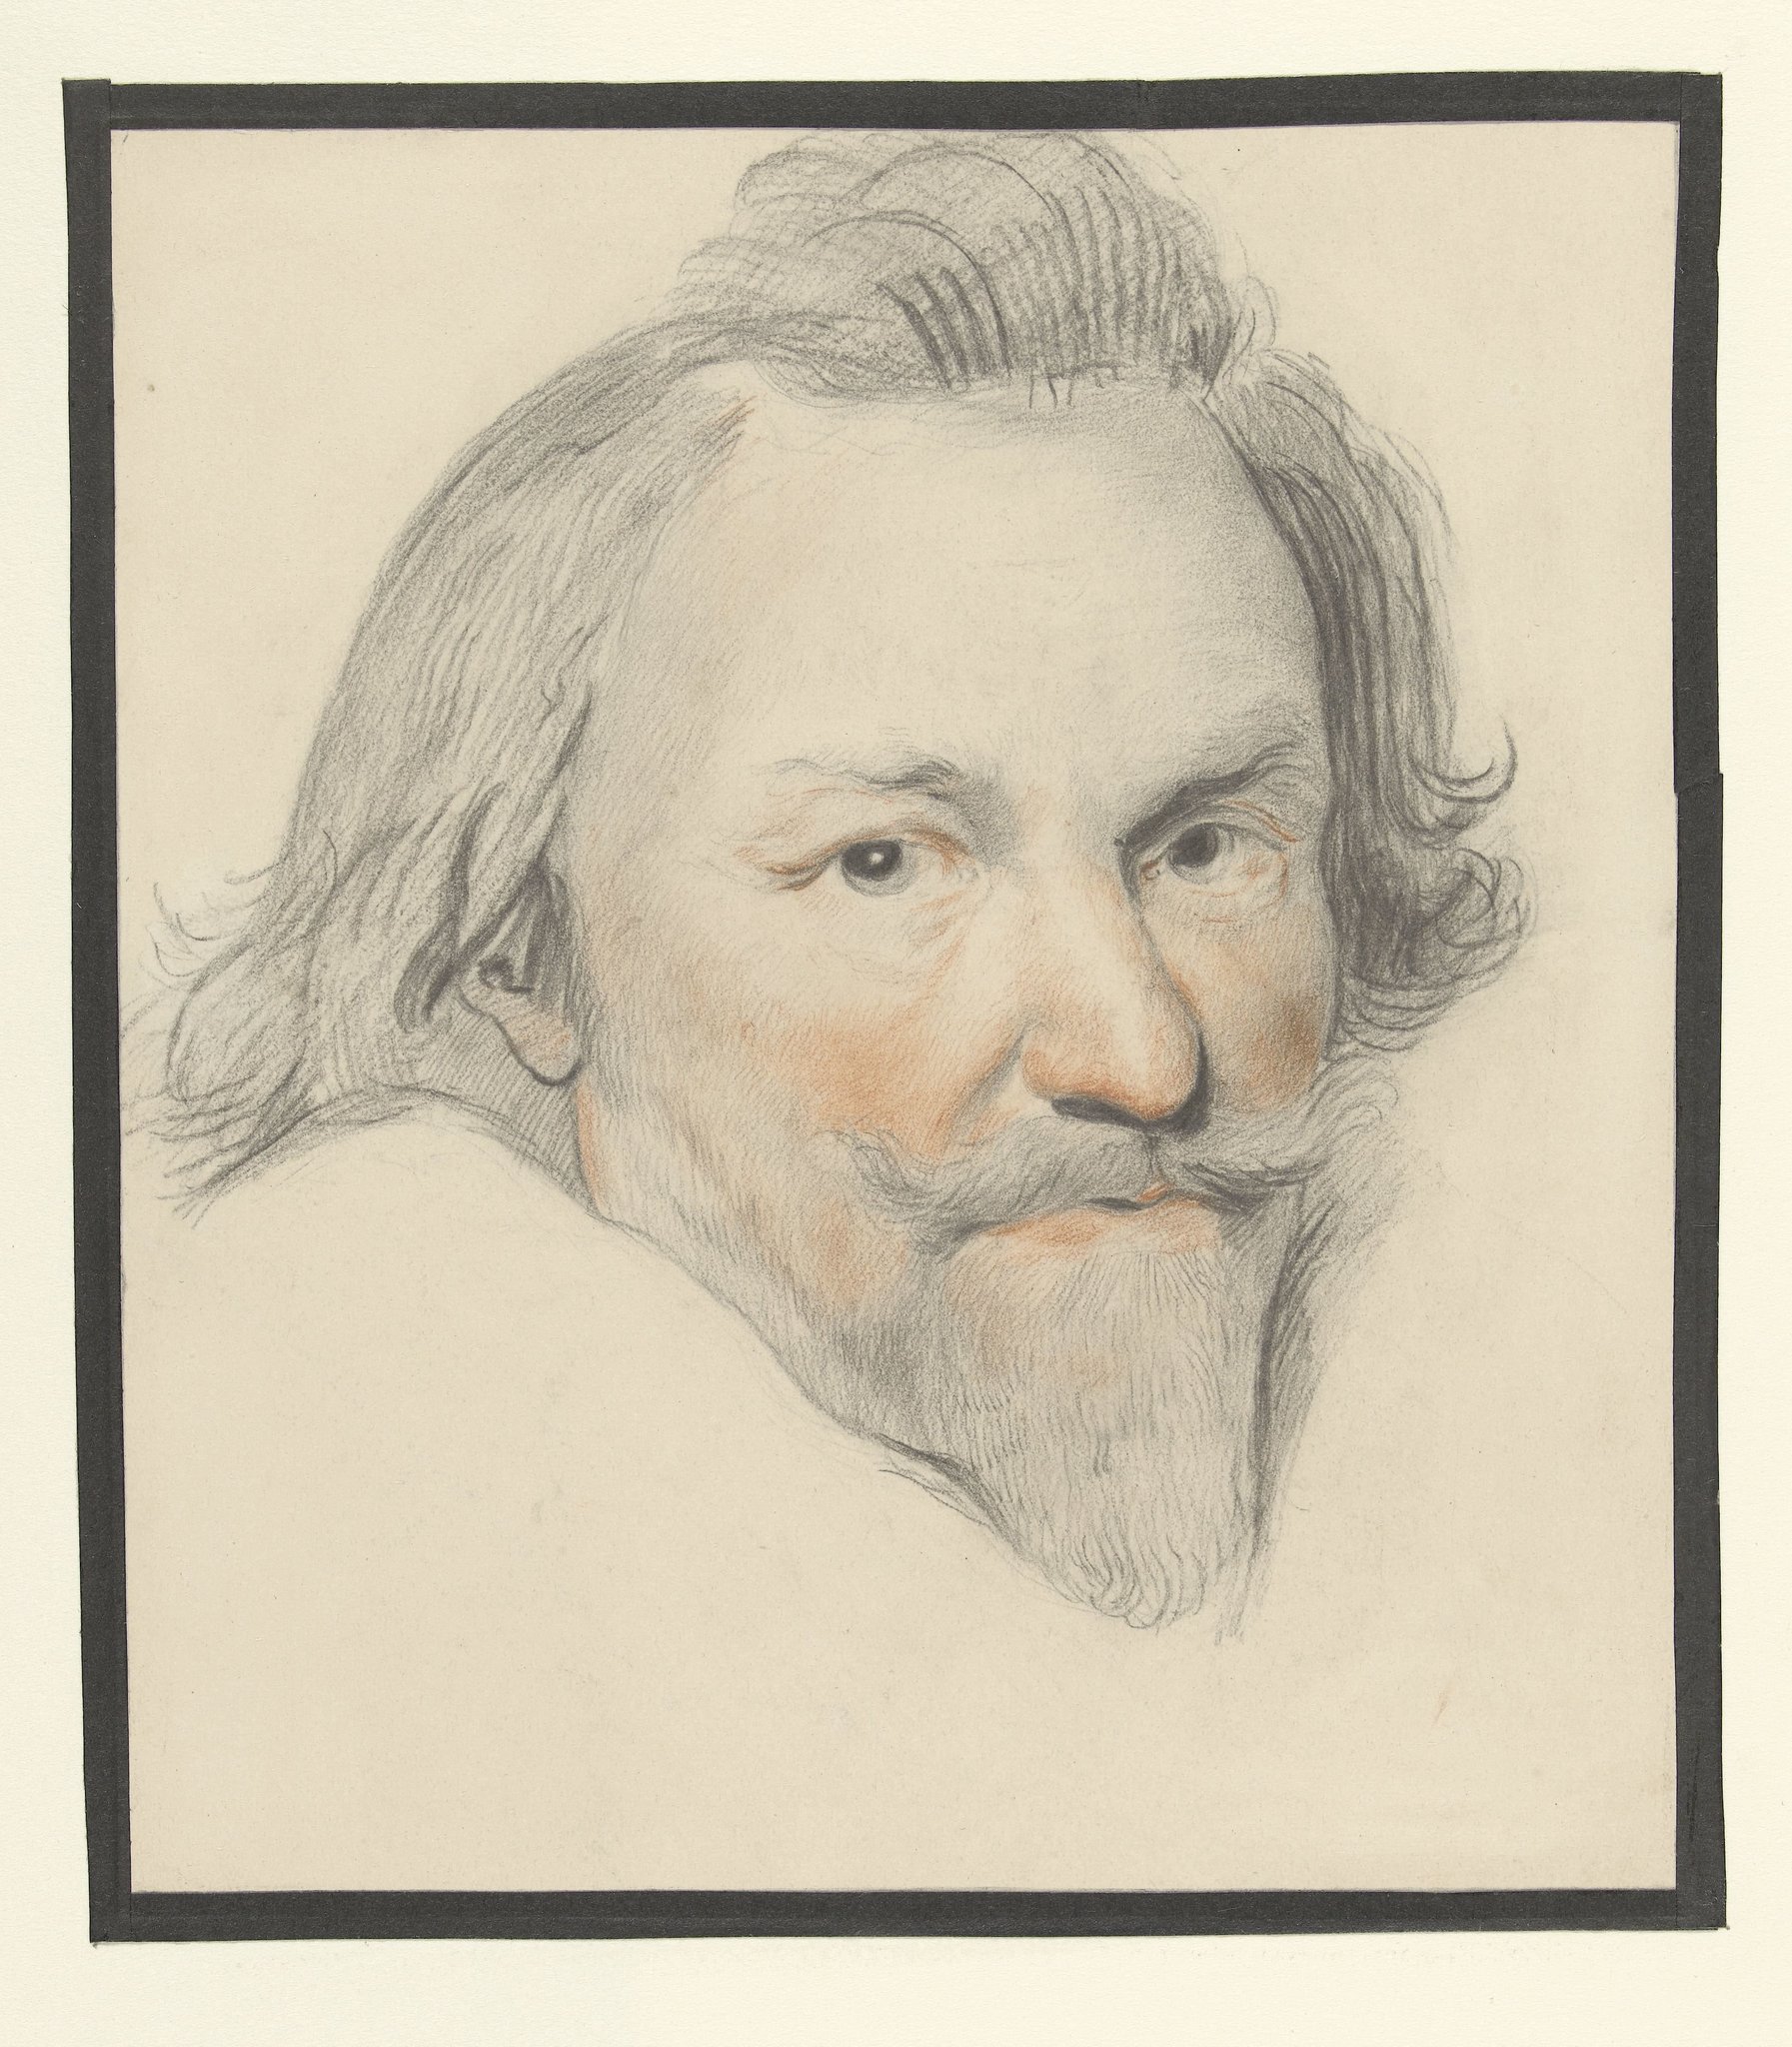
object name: drawing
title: Portret van Filips Willem, prins van Oranje-Nassau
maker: albertus brondgeest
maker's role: draughtsman, print maker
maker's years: 1786-1849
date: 1796-1849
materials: chalk, paper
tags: buren, filips willem (prins van oranje), historical persons